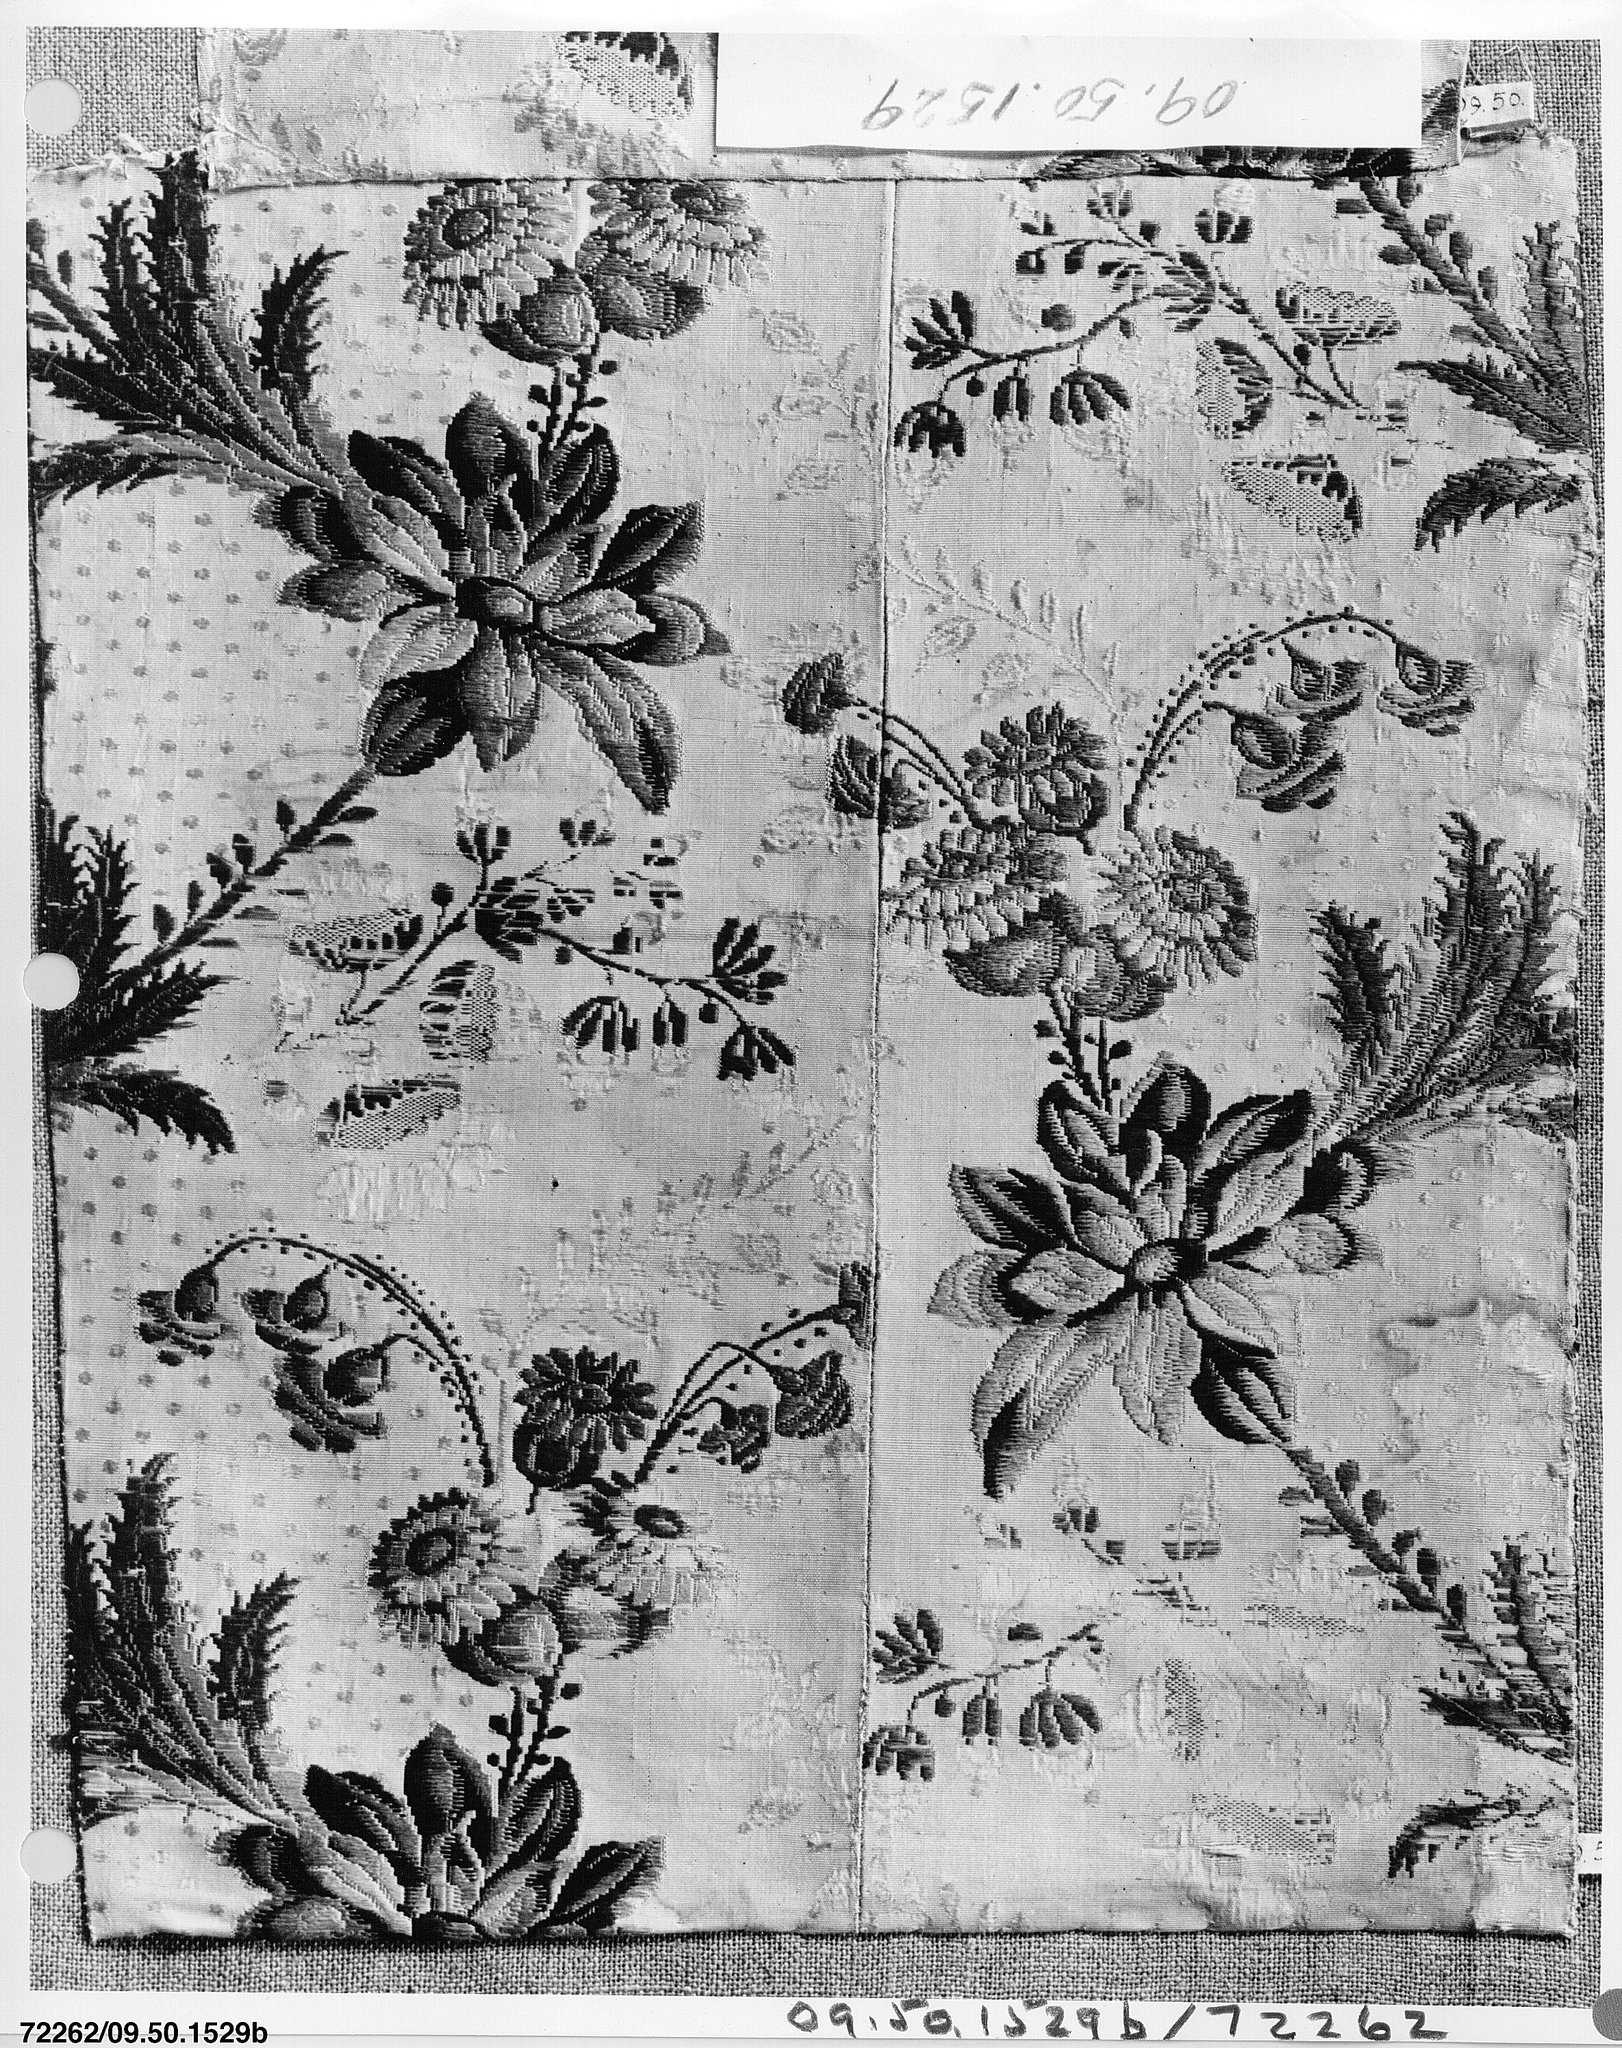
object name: piece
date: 1760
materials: silk